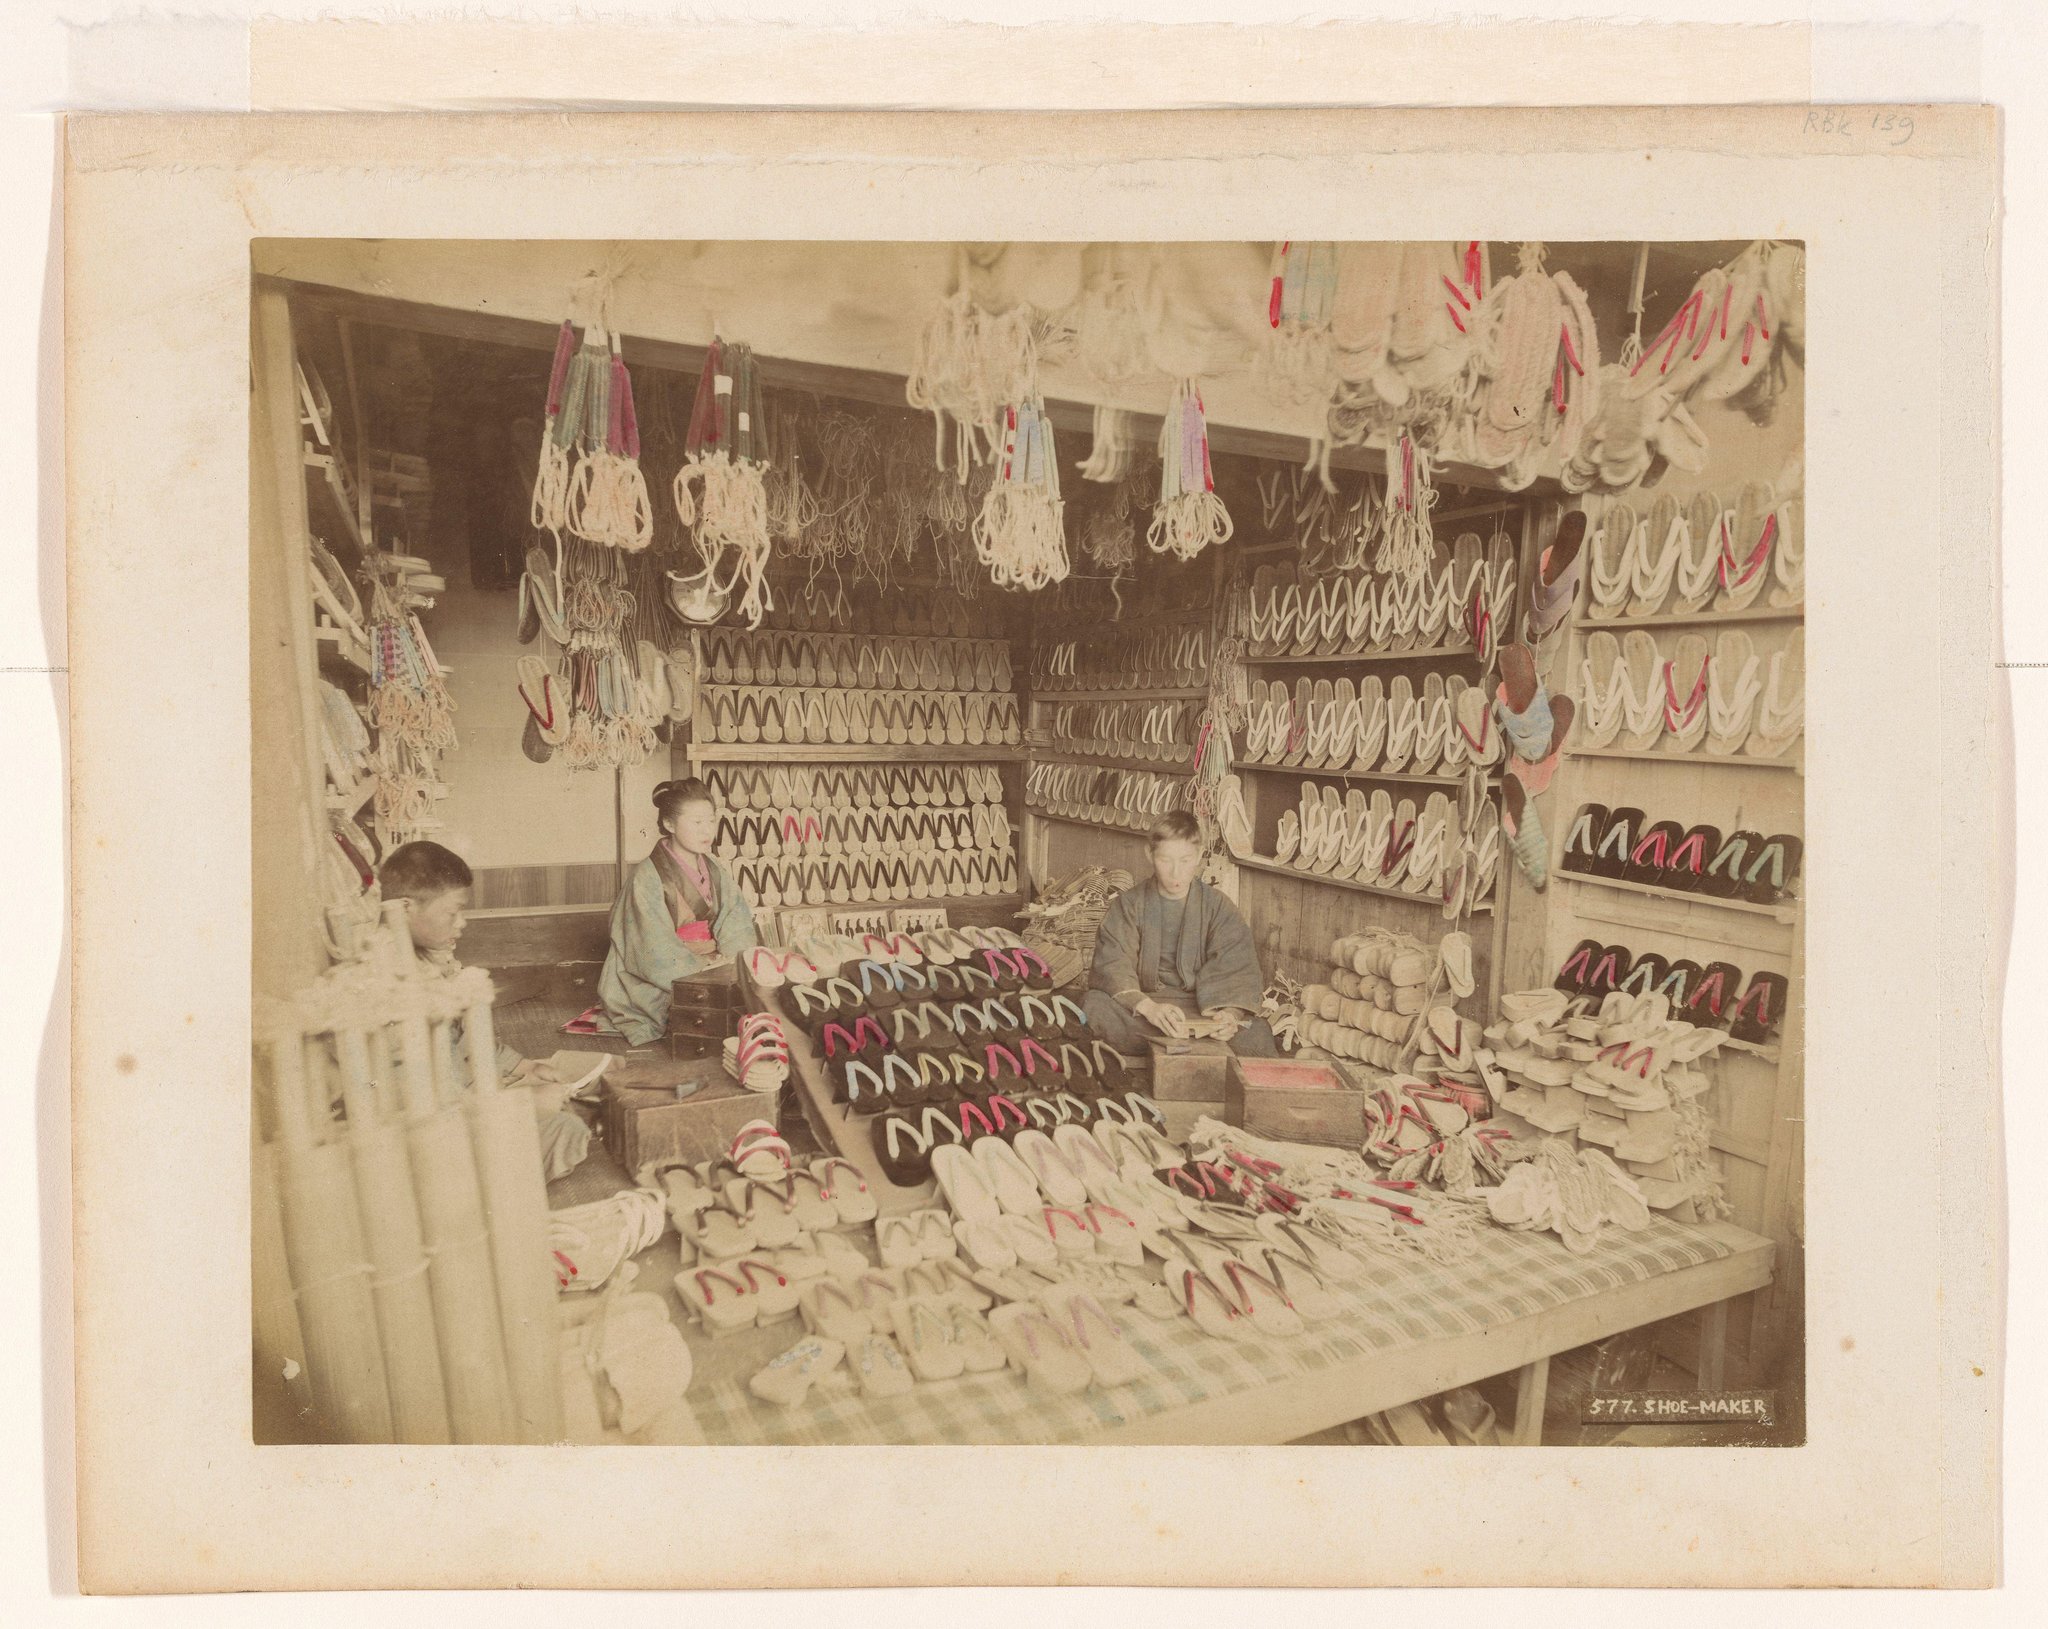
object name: photograph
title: Interieur van een Japanse getawinkel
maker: Anonymous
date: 1855-1890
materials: paper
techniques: albumen print, hand coloring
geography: japan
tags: shoes, sandals, shoe-maker, cobbler, japan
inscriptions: number: ‘577.’